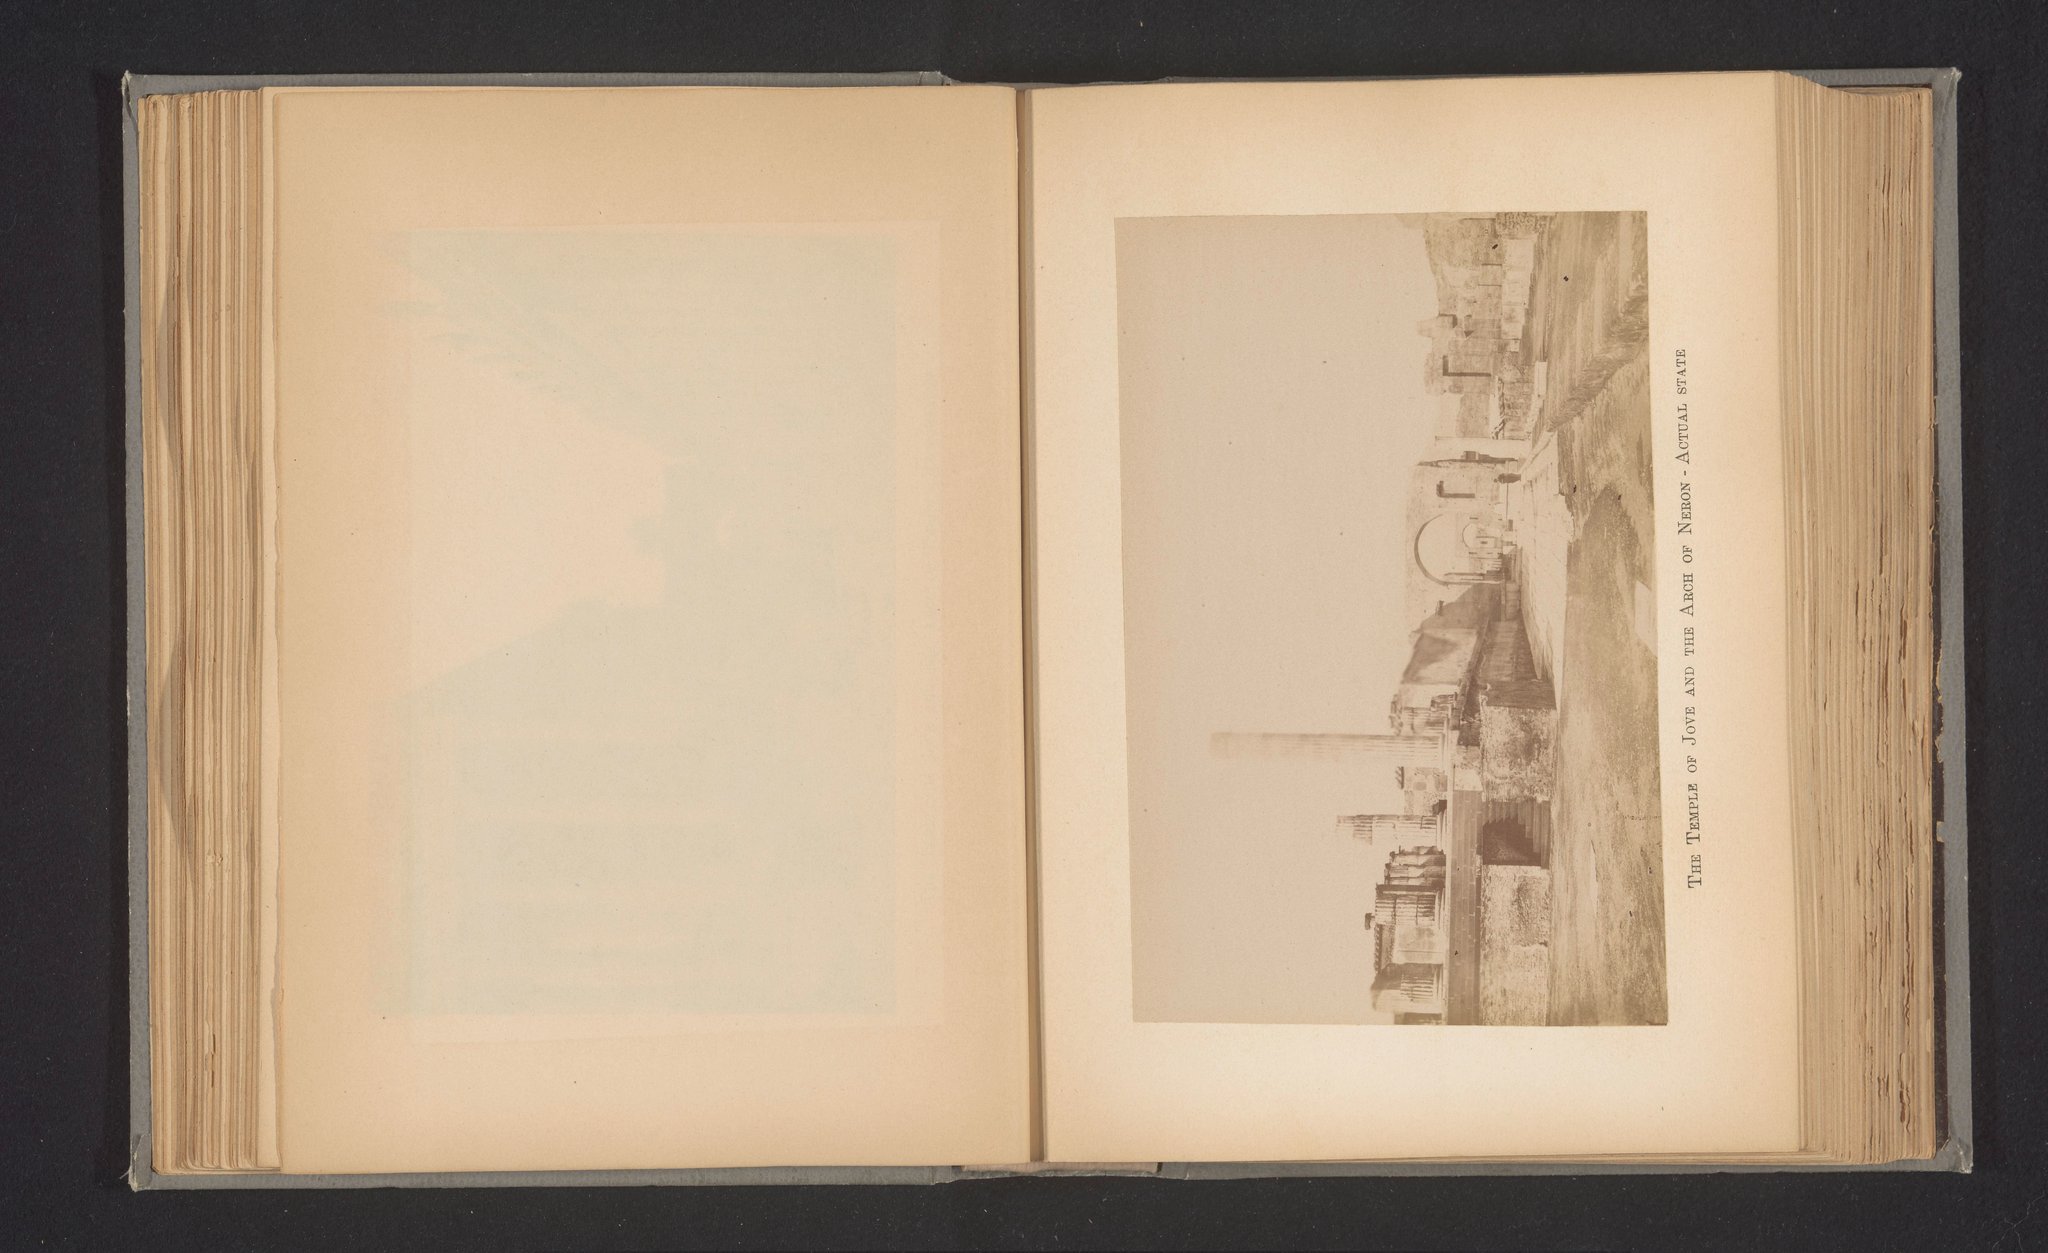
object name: page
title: The Temple of Jove and the Arch of Neron - Actual State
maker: Anonymous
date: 1890-1895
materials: photographic support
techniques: albumen print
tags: arch, archivolt ~ architecture, ruin of a dwelling, house, castle, etc.